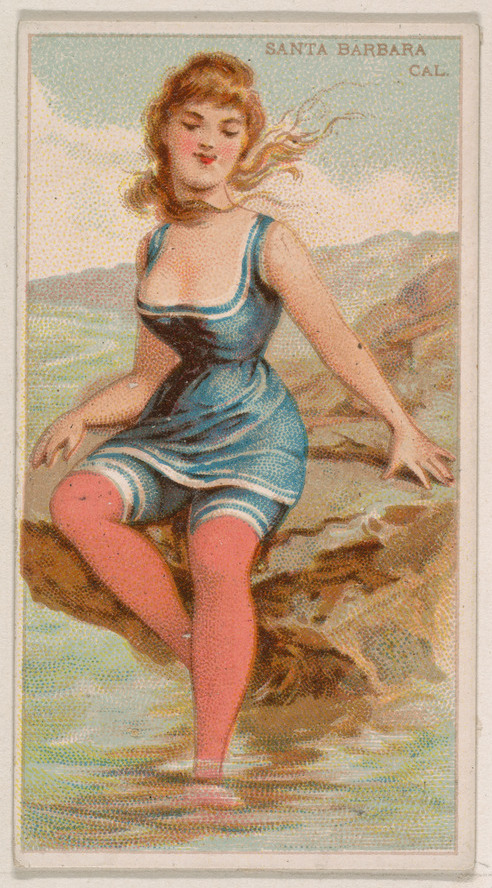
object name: print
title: Santa Barbara, California, from the Surf Beauties series (N232), issued by Kinney Bros.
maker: kinney brothers tobacco company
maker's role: publisher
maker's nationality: american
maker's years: 1869-2011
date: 1889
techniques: color lithograph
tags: girls,sports